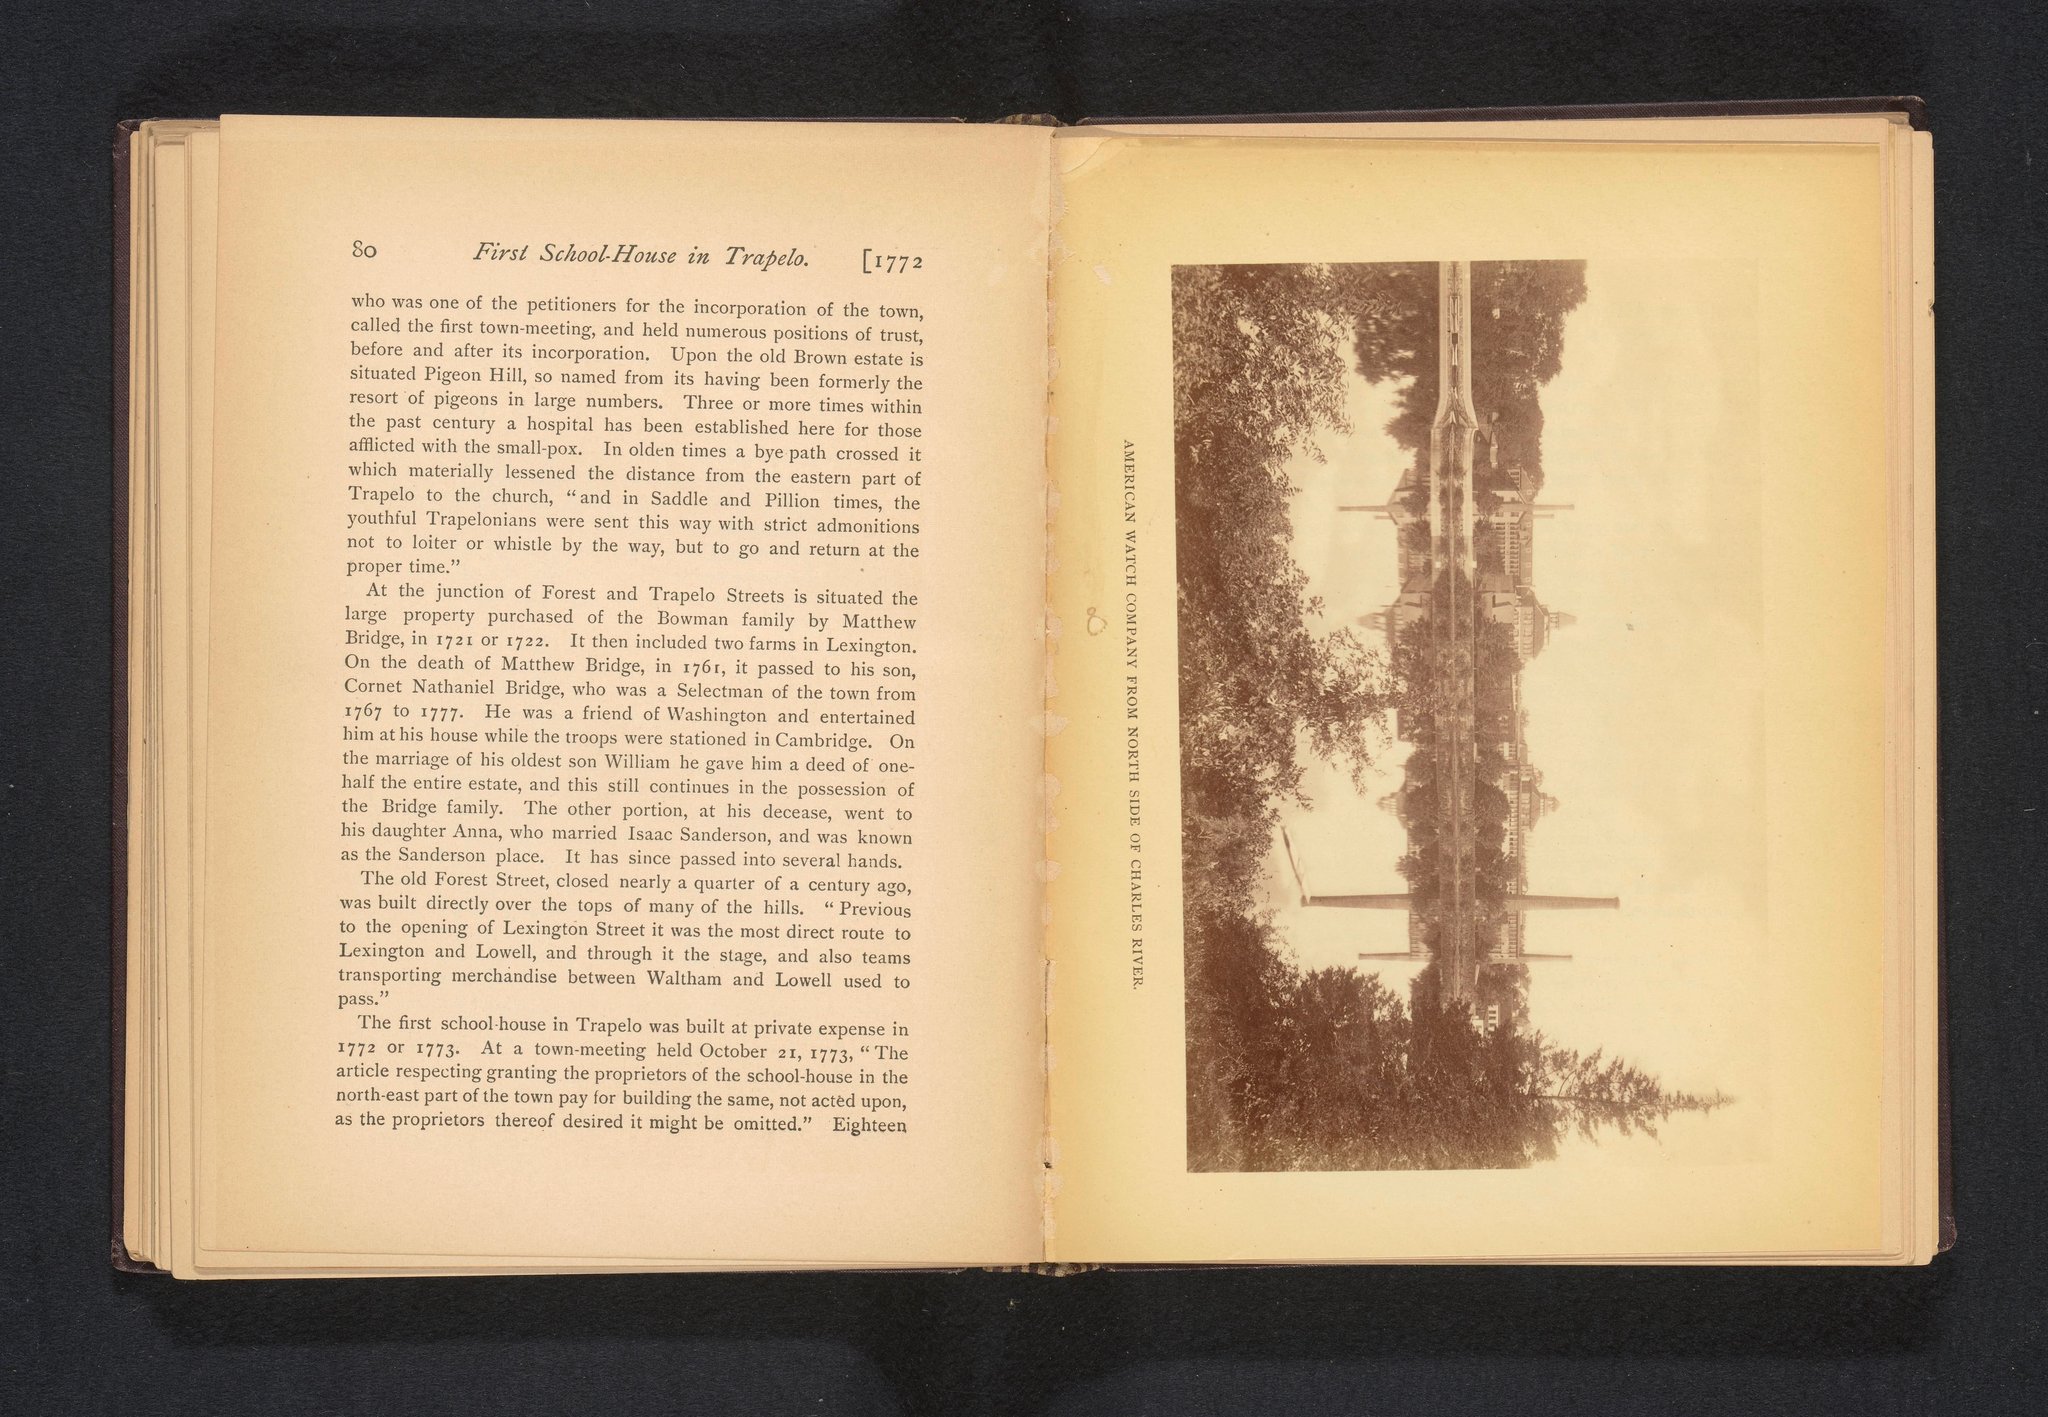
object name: page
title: American Watch Company from North Side of Charles River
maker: thomas r. lewis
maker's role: publisher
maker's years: 1845-1901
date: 1874-1879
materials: photographic support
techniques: albumen print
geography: waltham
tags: factory-building